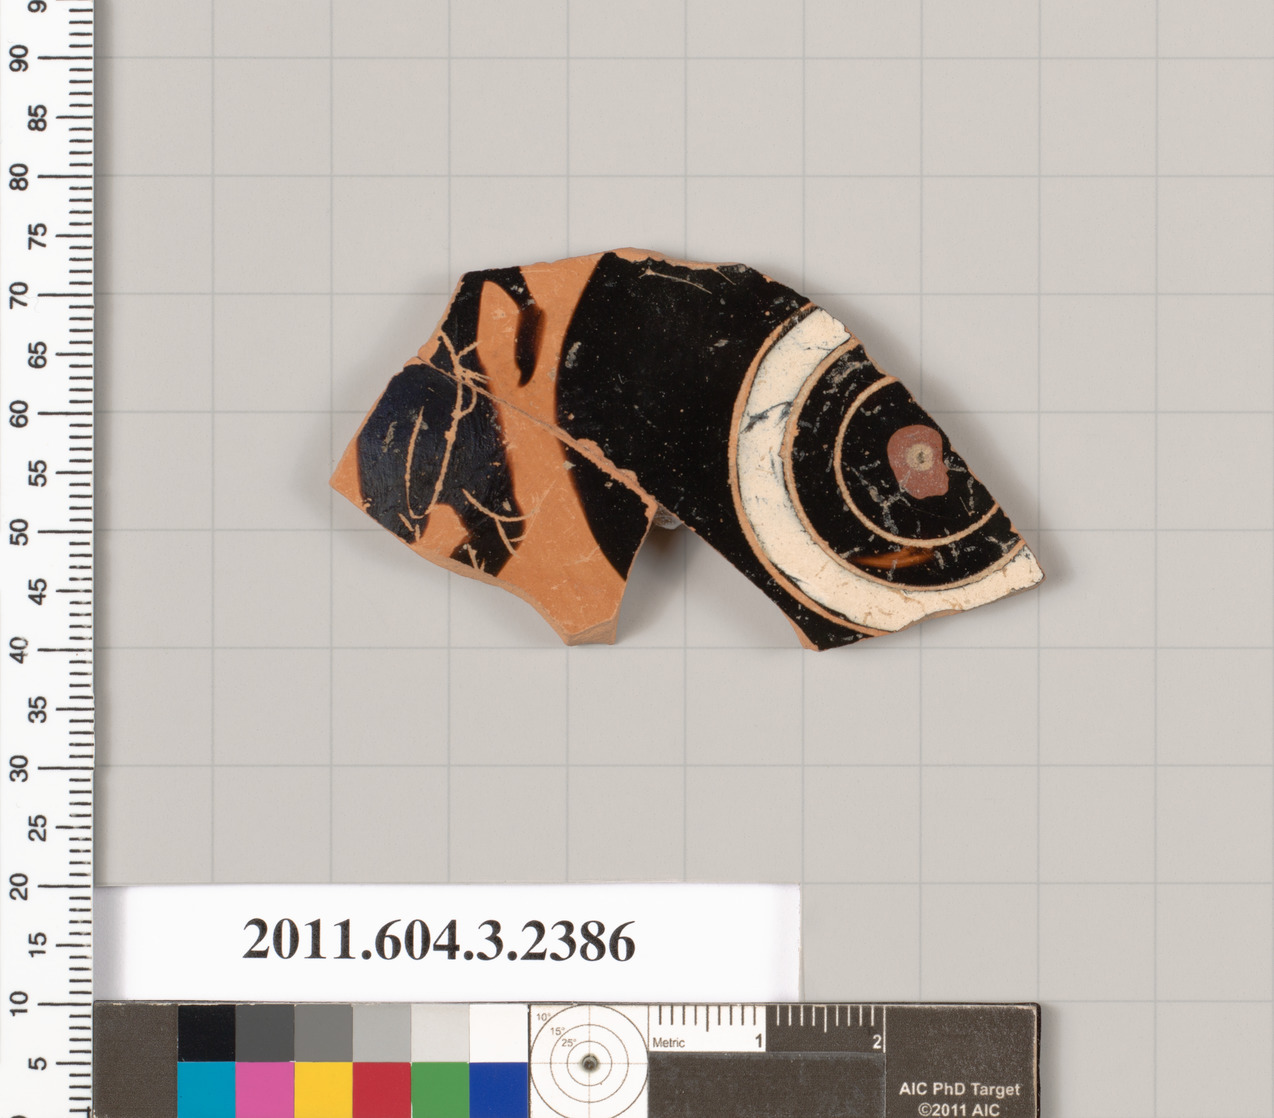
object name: kylix fragment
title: Terracotta fragment of a kylix: eye-cup (drinking cup)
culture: greek, attic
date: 520-510 BCE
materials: terracotta